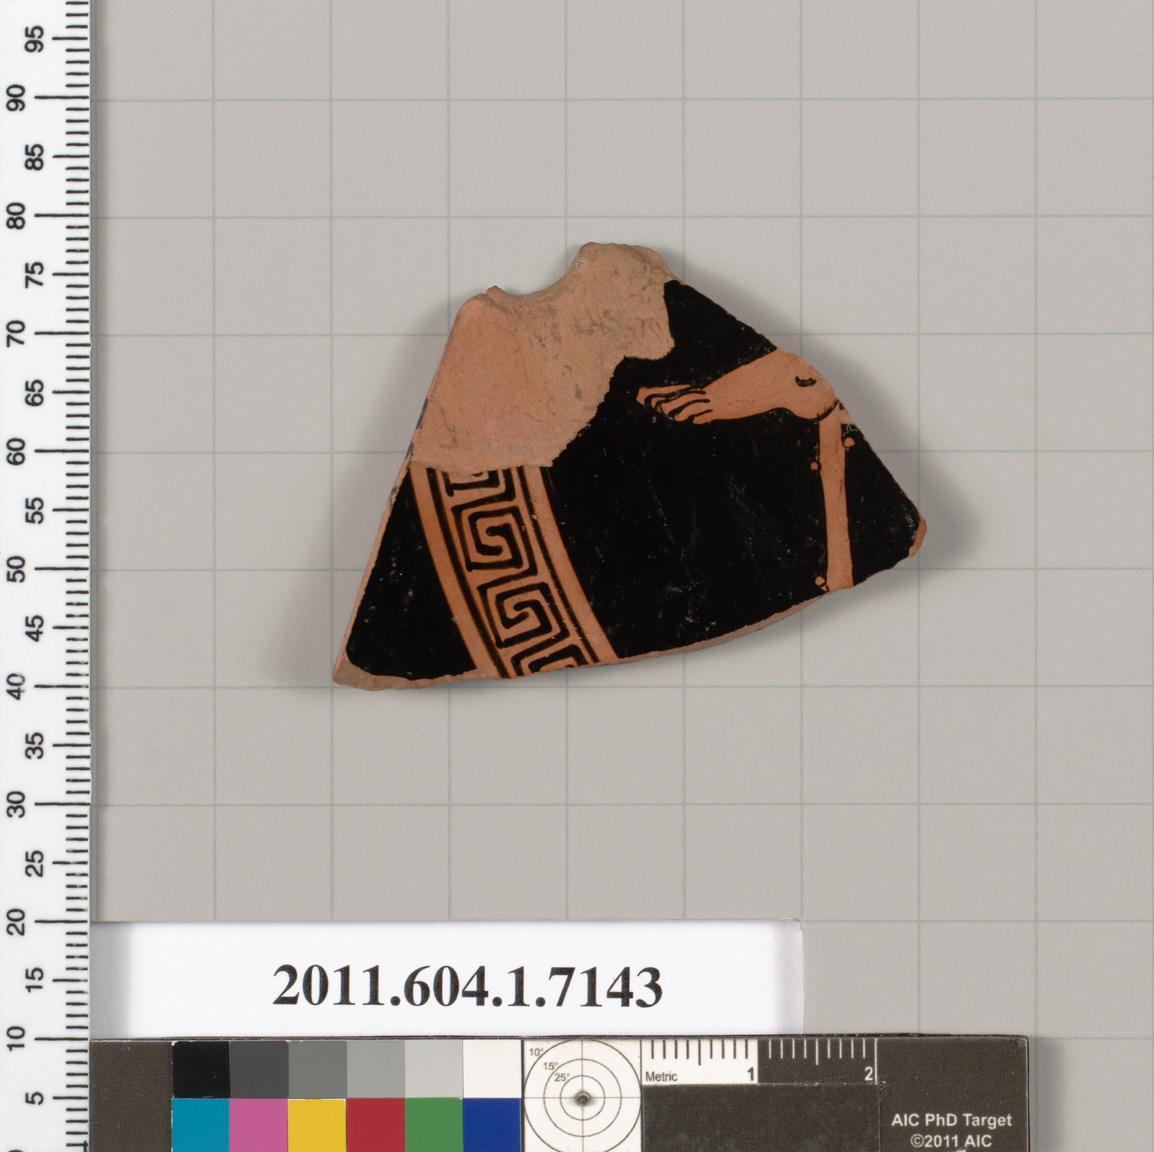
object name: kylix fragment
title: Terracotta fragment of a kylix (drinking cup)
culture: greek, attic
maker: makron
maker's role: artist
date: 500-480 BCE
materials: terracotta